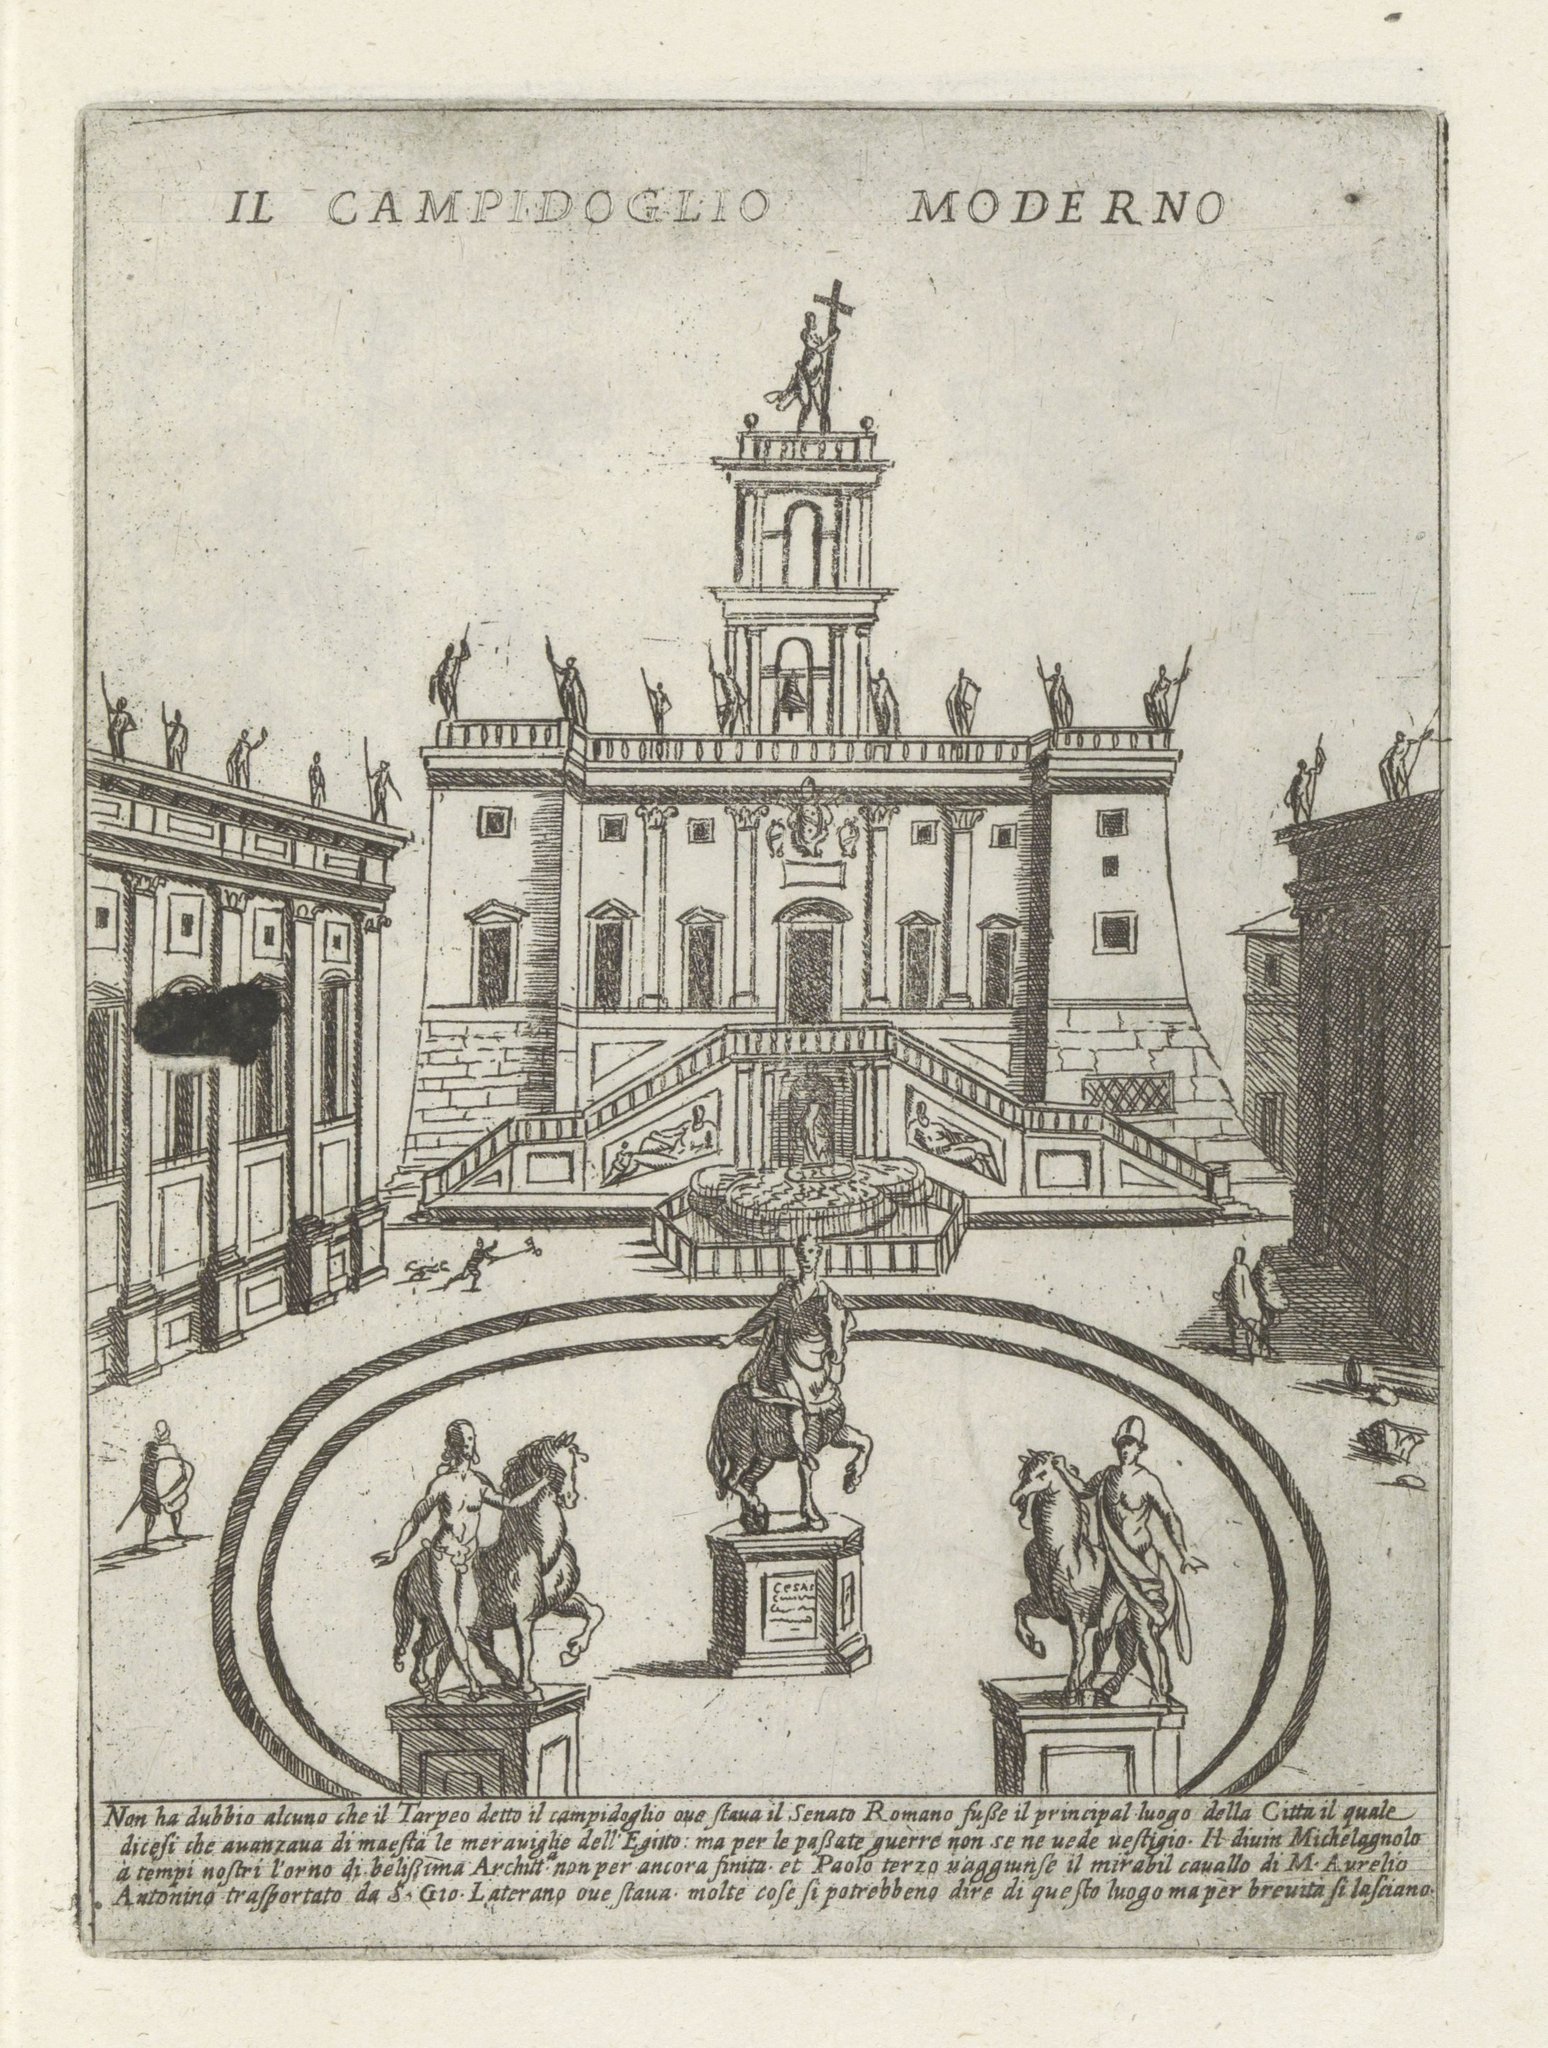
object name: album leaf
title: Il Campidoglio moderno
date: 1576-1618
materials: paper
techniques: etching, intaglio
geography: rome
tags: obelisk, needle, church (exterior)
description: Gezicht op de Capitool heuvel te Rome. Italiaanse tekst in ondermarge. Prent maakt deel uit van een album.